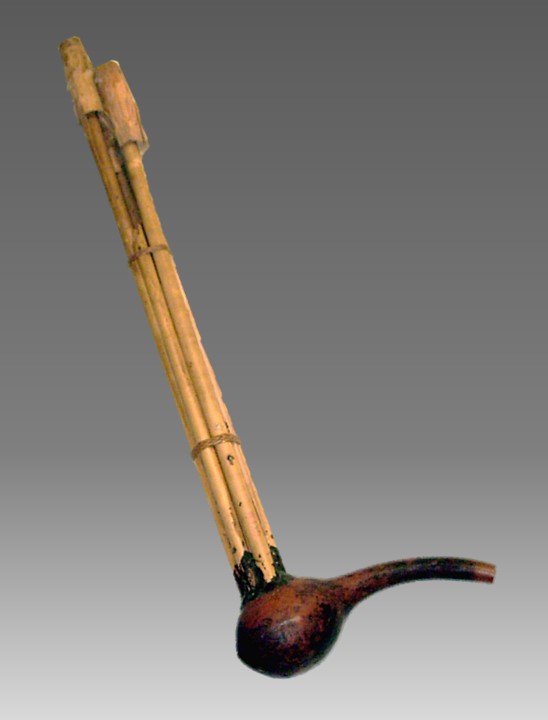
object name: engkerurai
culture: iban people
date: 1867-1900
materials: bamboo, rattan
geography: borneo